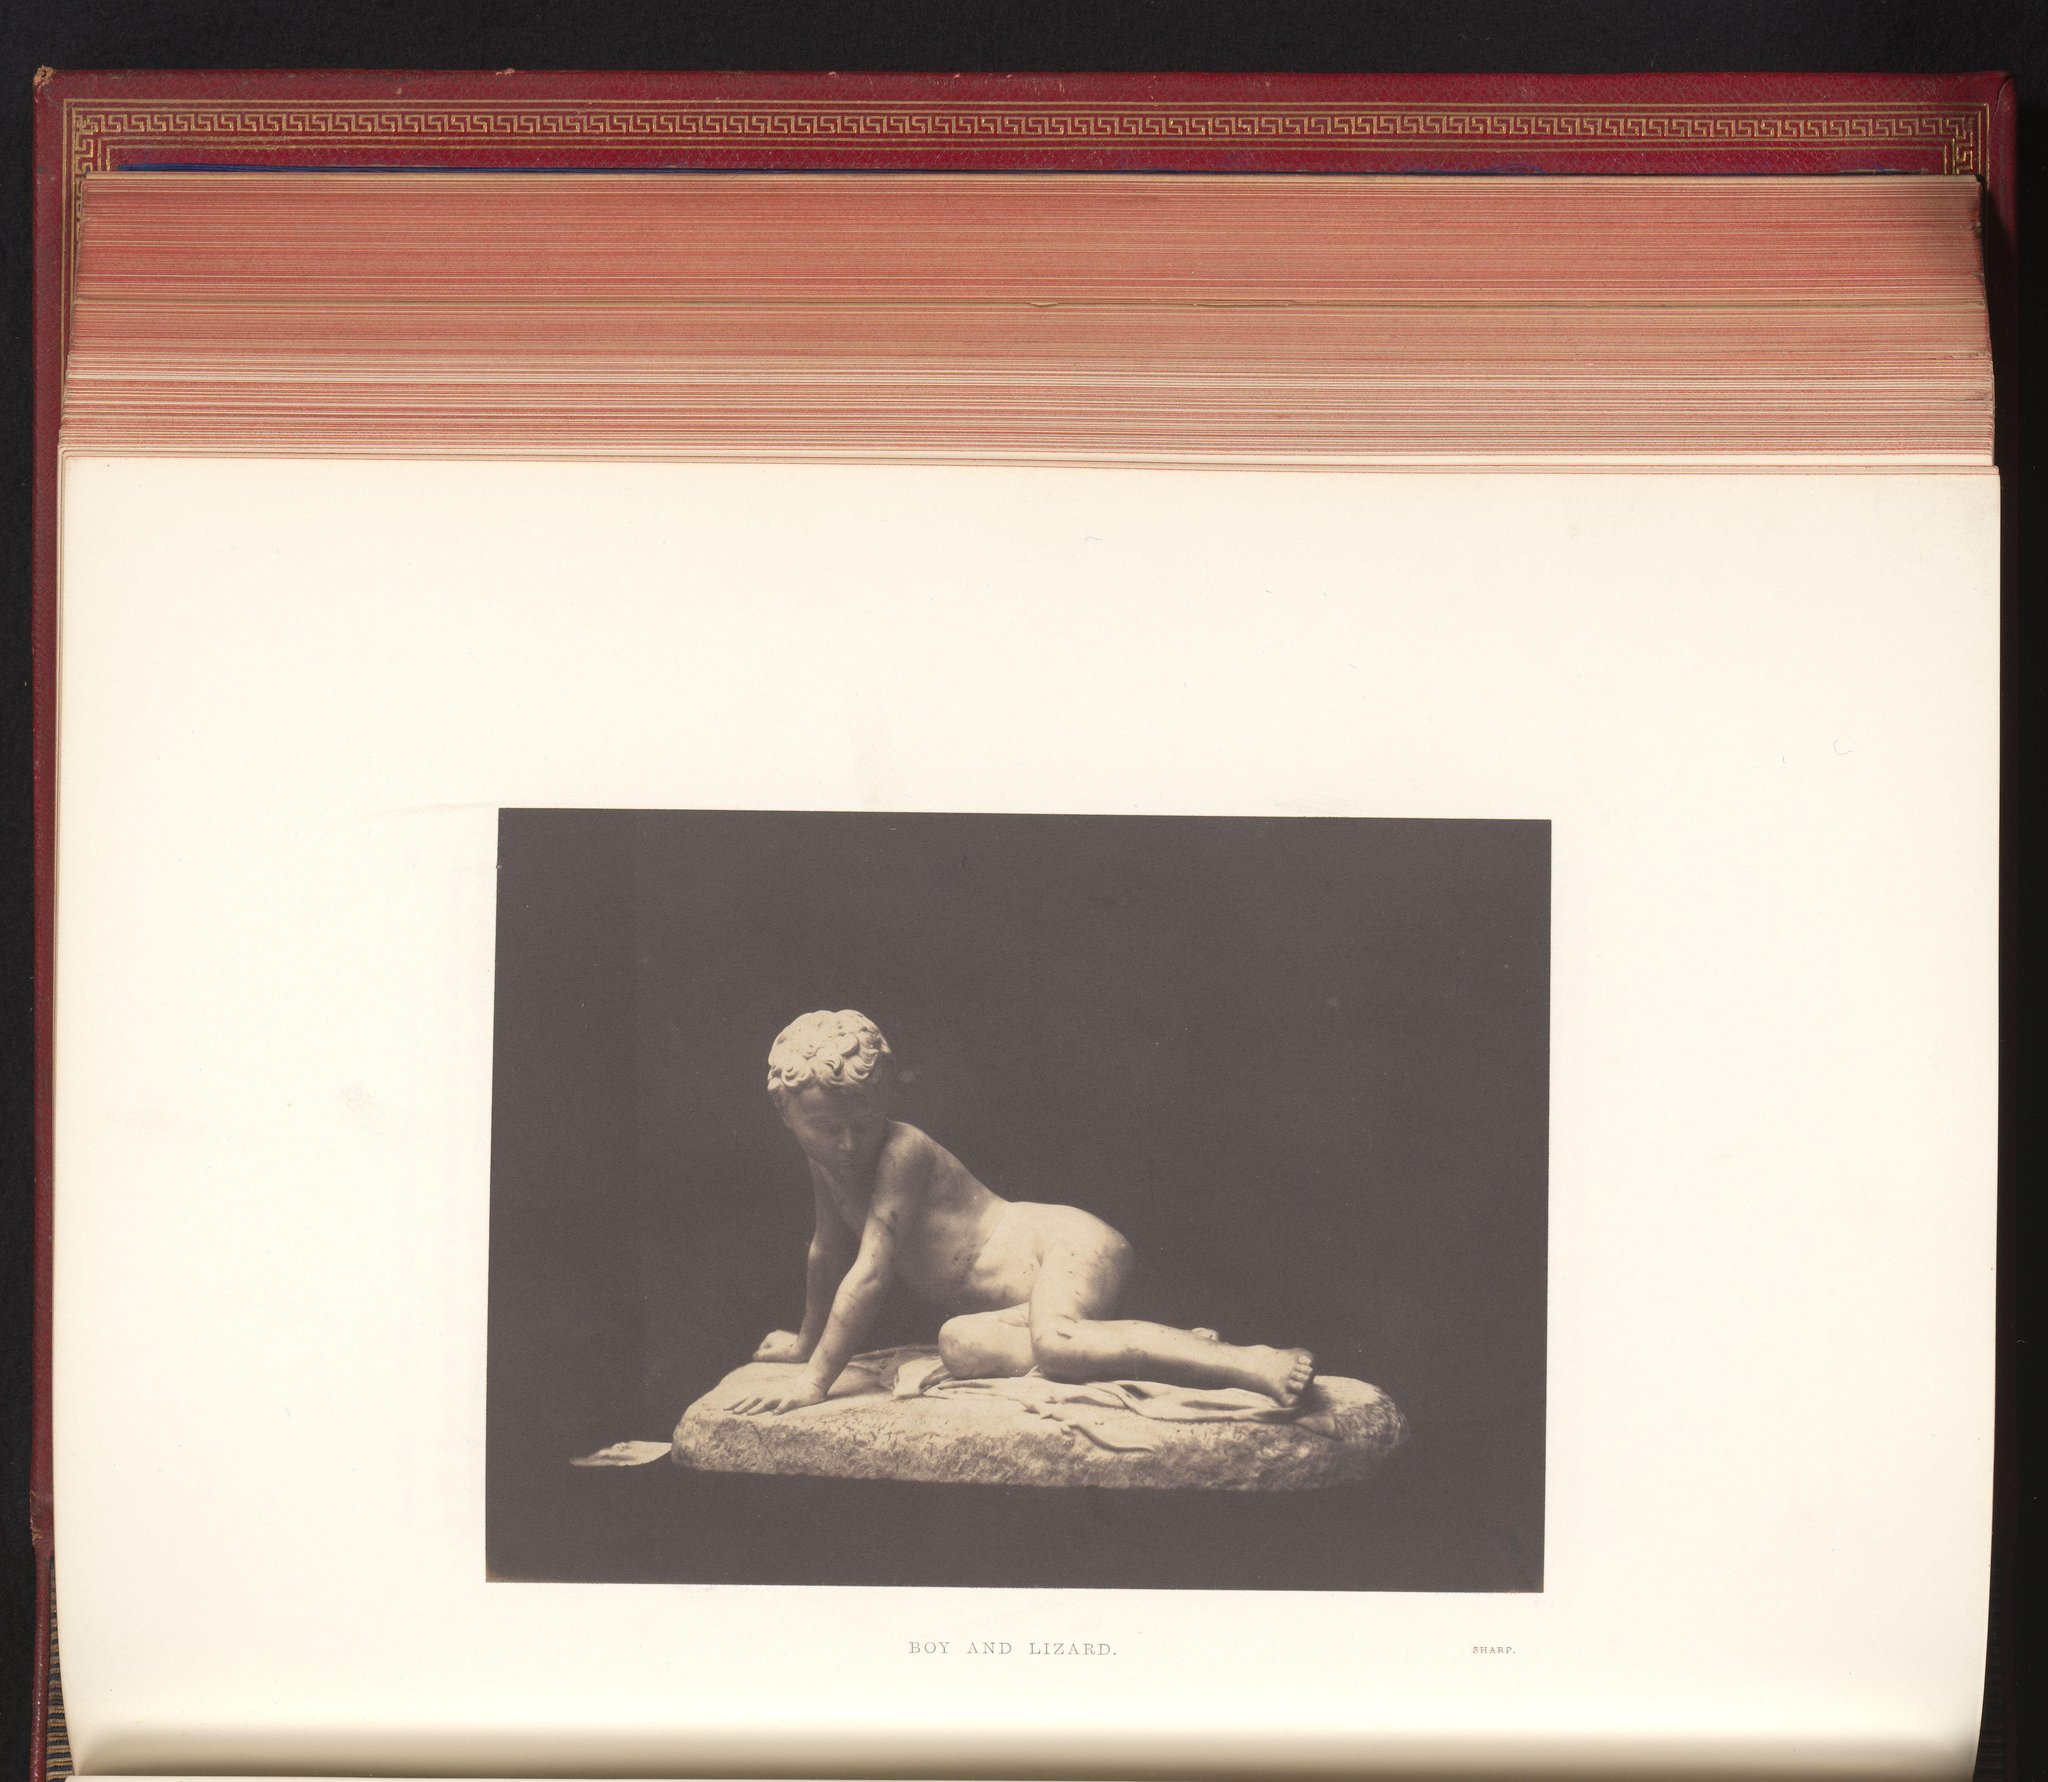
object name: page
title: Boy and Lizard. Sharp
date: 1851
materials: photographic support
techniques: salted paper print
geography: london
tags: piece of sculpture, reproduction of a piece of sculpture, london